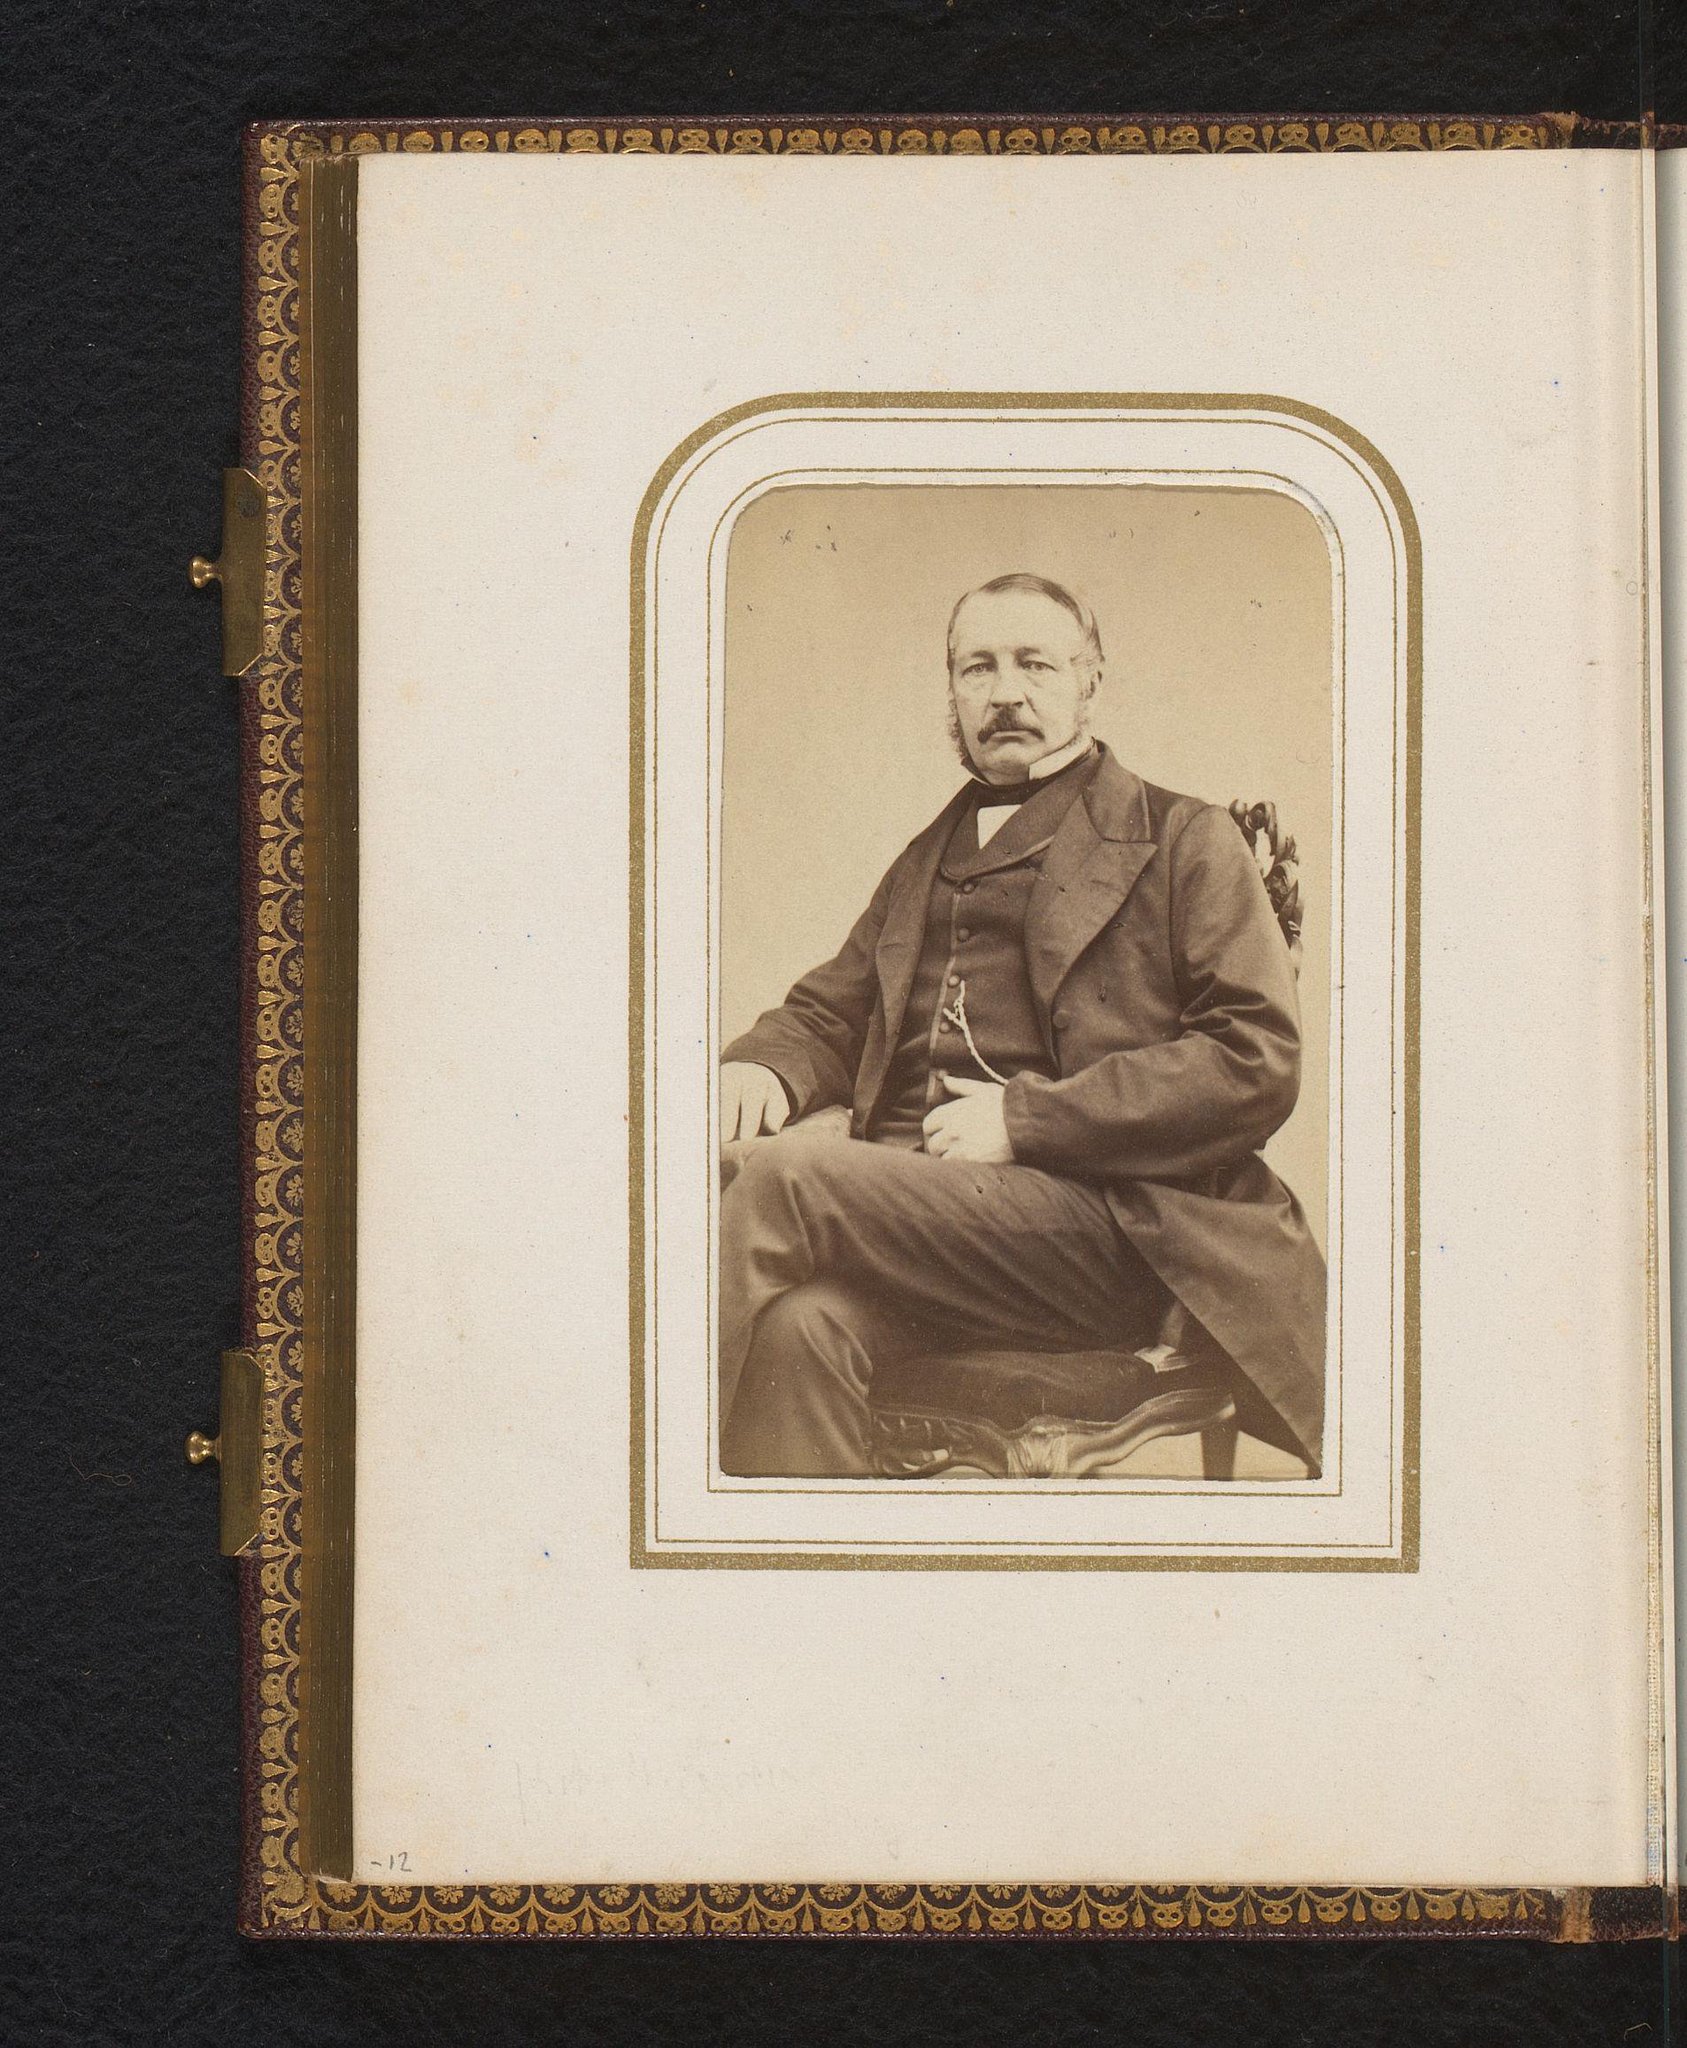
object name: album leaf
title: Portret van een onbekende man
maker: maurits verveer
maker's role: painter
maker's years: 1817-1903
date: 1861-1863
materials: cardboard, paper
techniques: albumen print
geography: the hague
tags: anonymous historical person portrayed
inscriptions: address: ‘46, ZEESTRAAT, 46./ VIS A VIS DU WILLEMSPARK/ LA HAYE’